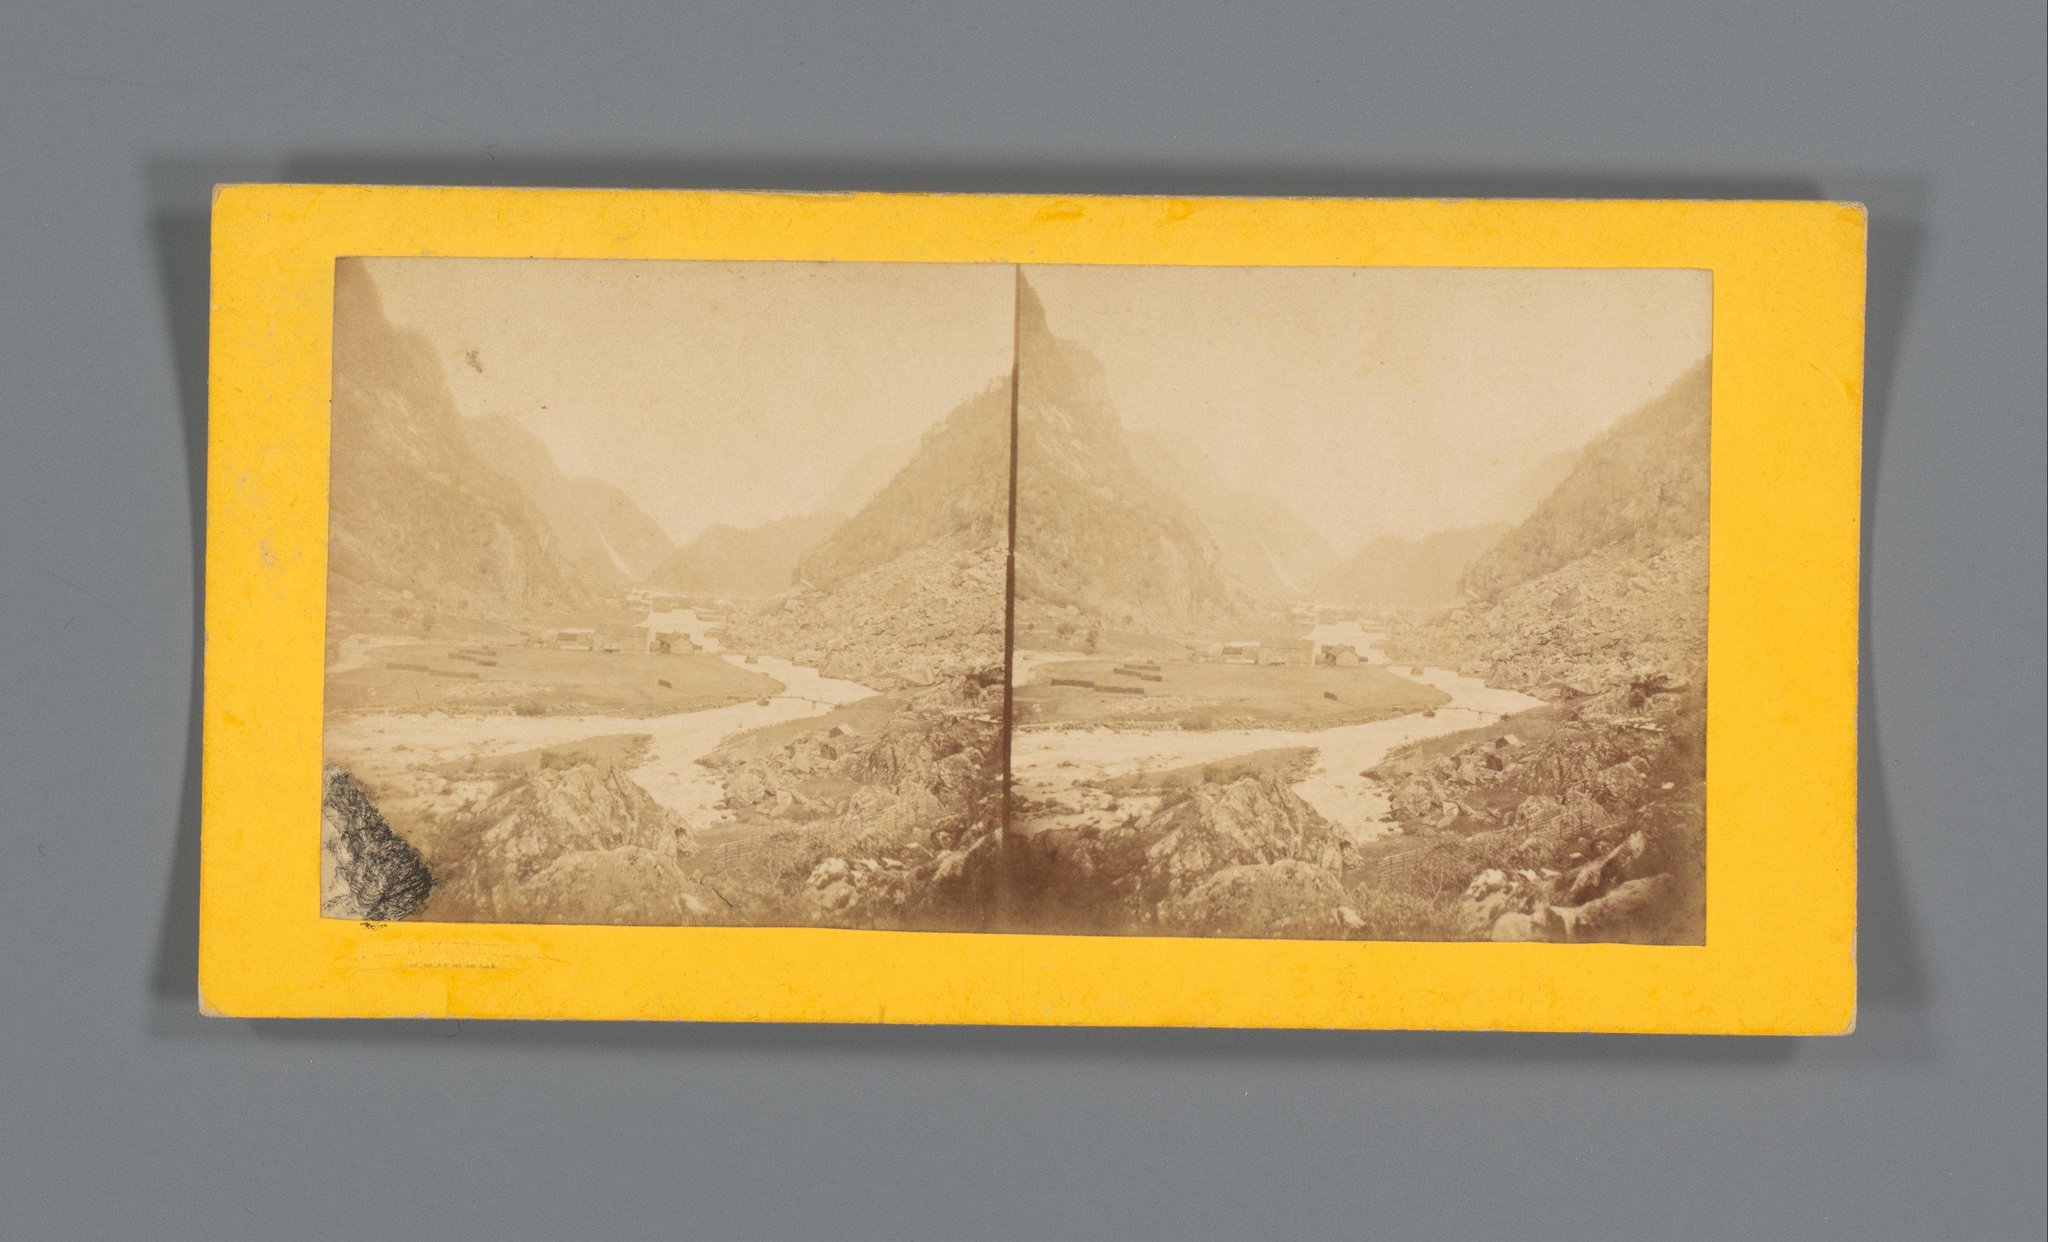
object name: stereograph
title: Parti af Grönsdal, Odde, Hardanger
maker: knud knudsen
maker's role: fotograaf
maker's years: 1832-1915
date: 1861-1870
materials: cardboard, paper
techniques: albumen print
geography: odda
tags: fjord, sea loch, mountains